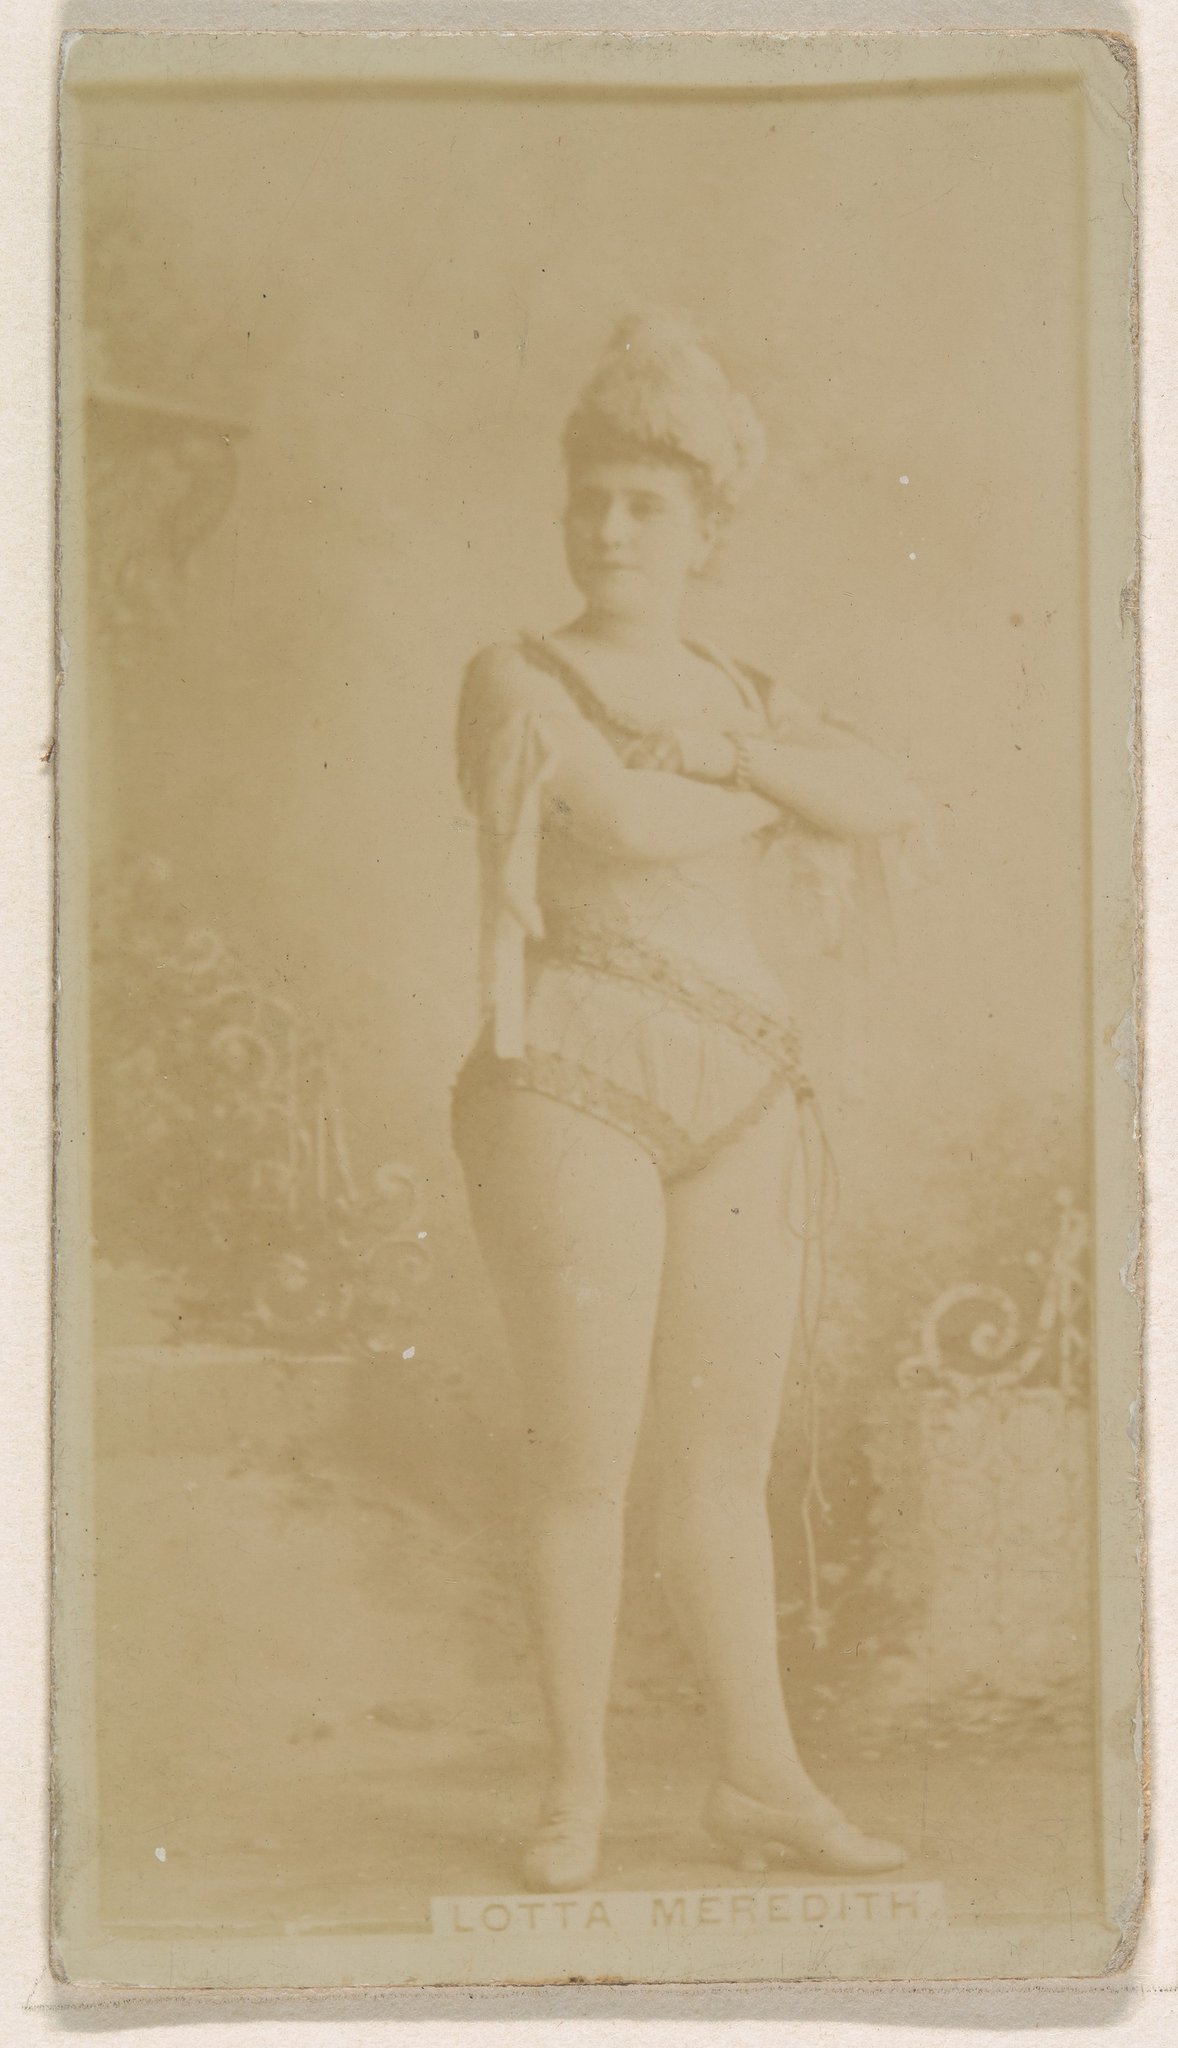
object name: photograph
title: Lotta Meredith, from the Actresses series (N245) issued by Kinney Brothers to promote Sweet Caporal Cigarettes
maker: kinney brothers tobacco company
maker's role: publisher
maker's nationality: american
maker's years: 1869-2011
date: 1890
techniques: albumen silver print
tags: portraits,women,actresses